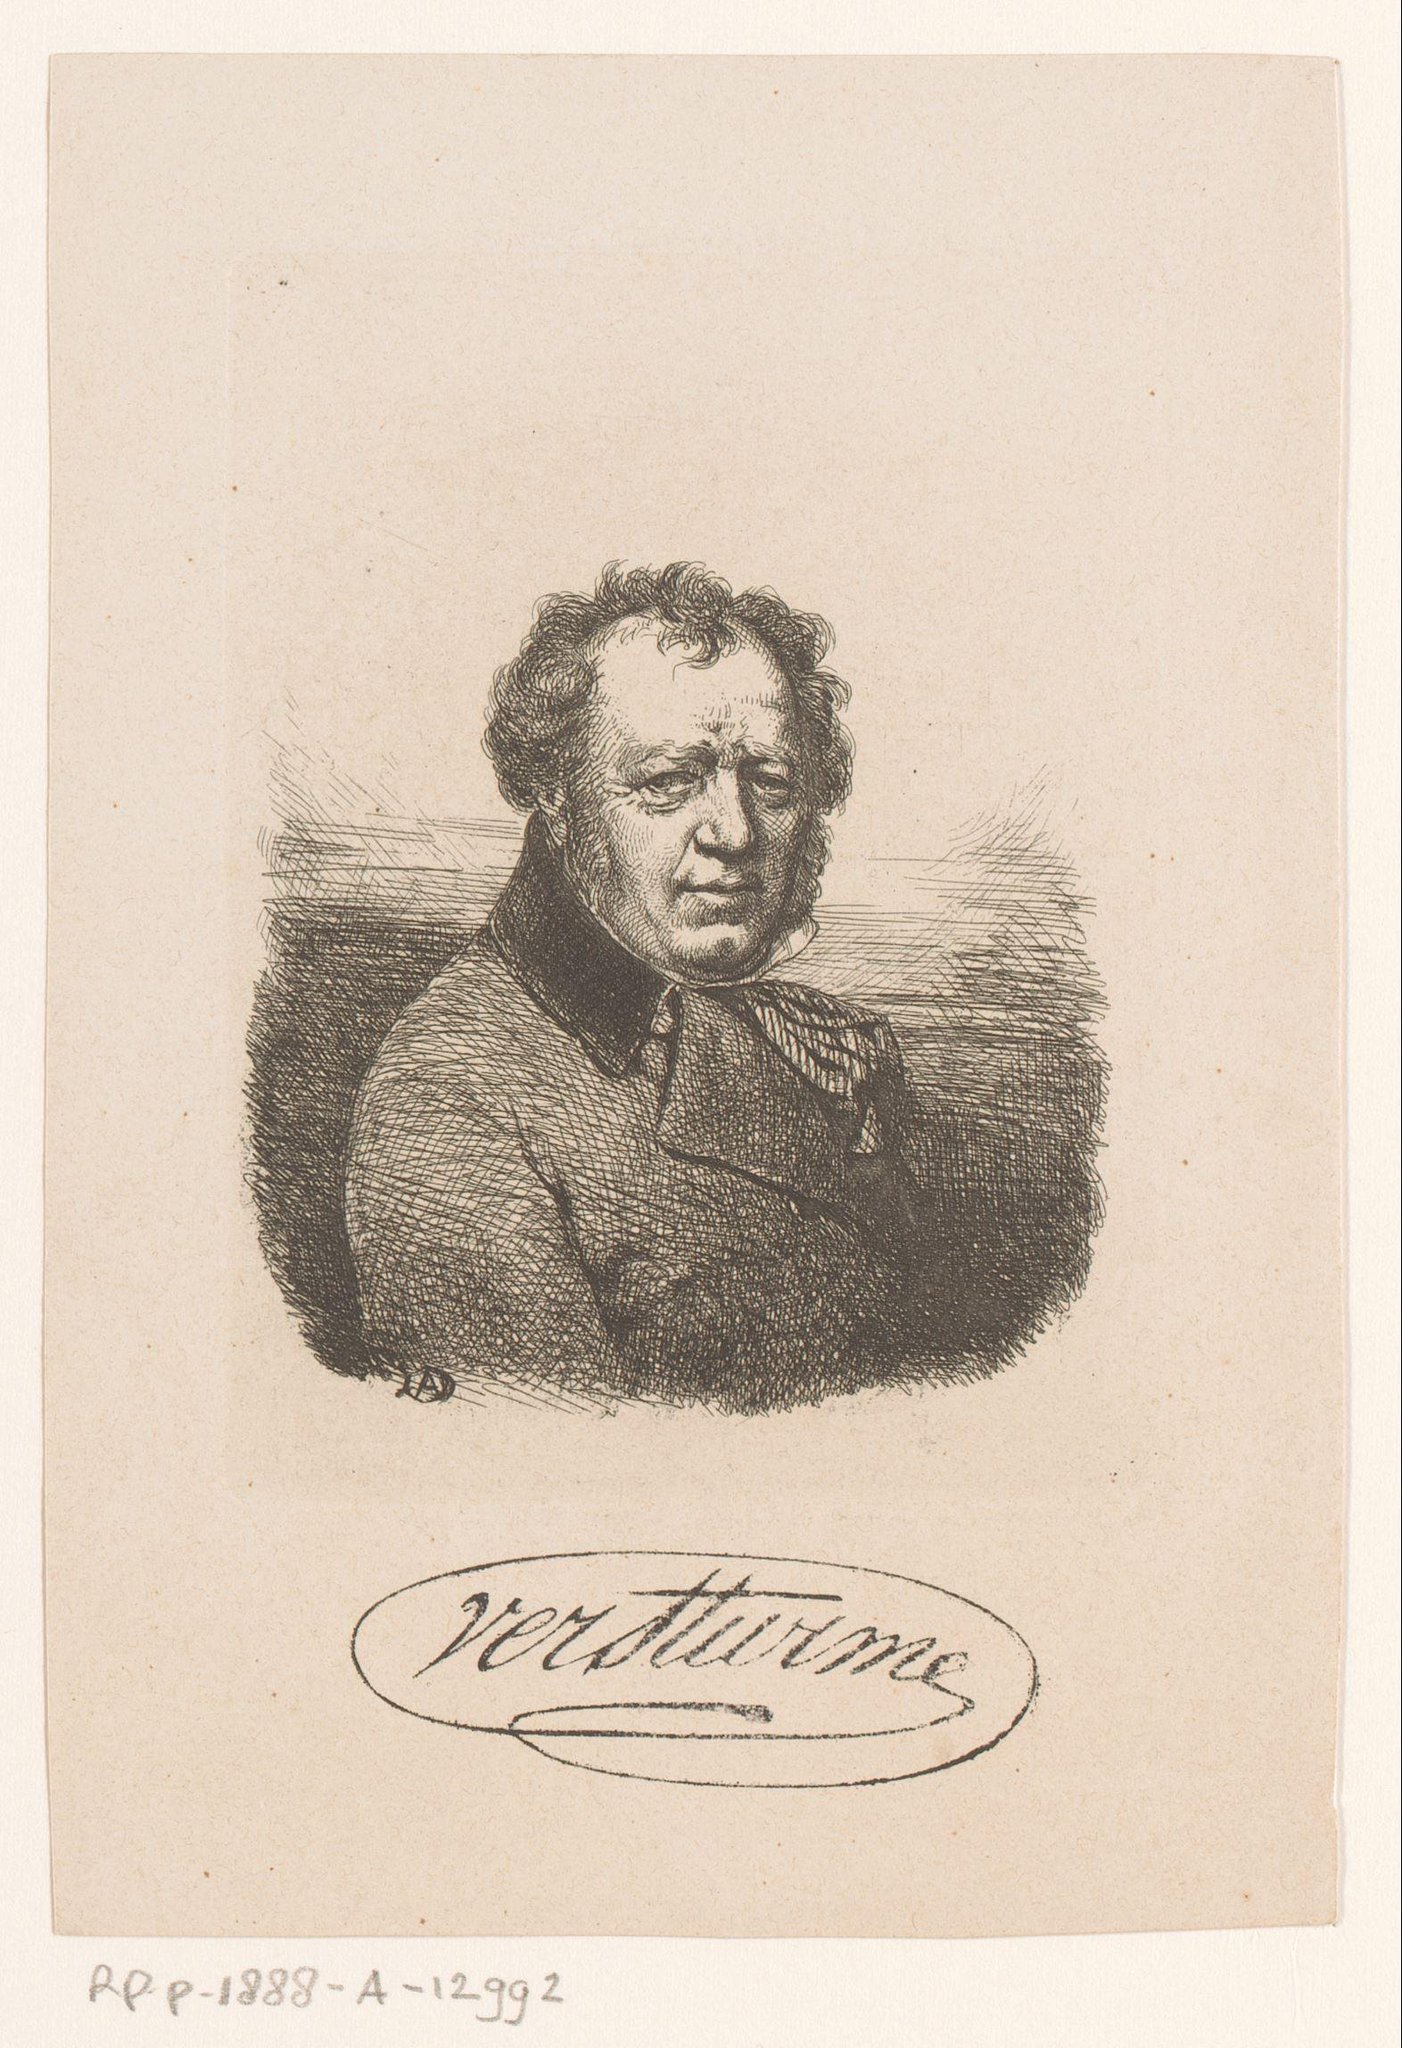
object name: print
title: Portret van Pierre Joseph Versturme-Roegiers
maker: adolphe alexandre dillens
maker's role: draughtsman, painter, print maker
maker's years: 1821-1877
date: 1831-1877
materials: paper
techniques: etching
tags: adult man, historical persons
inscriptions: inscription: ‘Versturme’, collector's mark: Lugt 2228